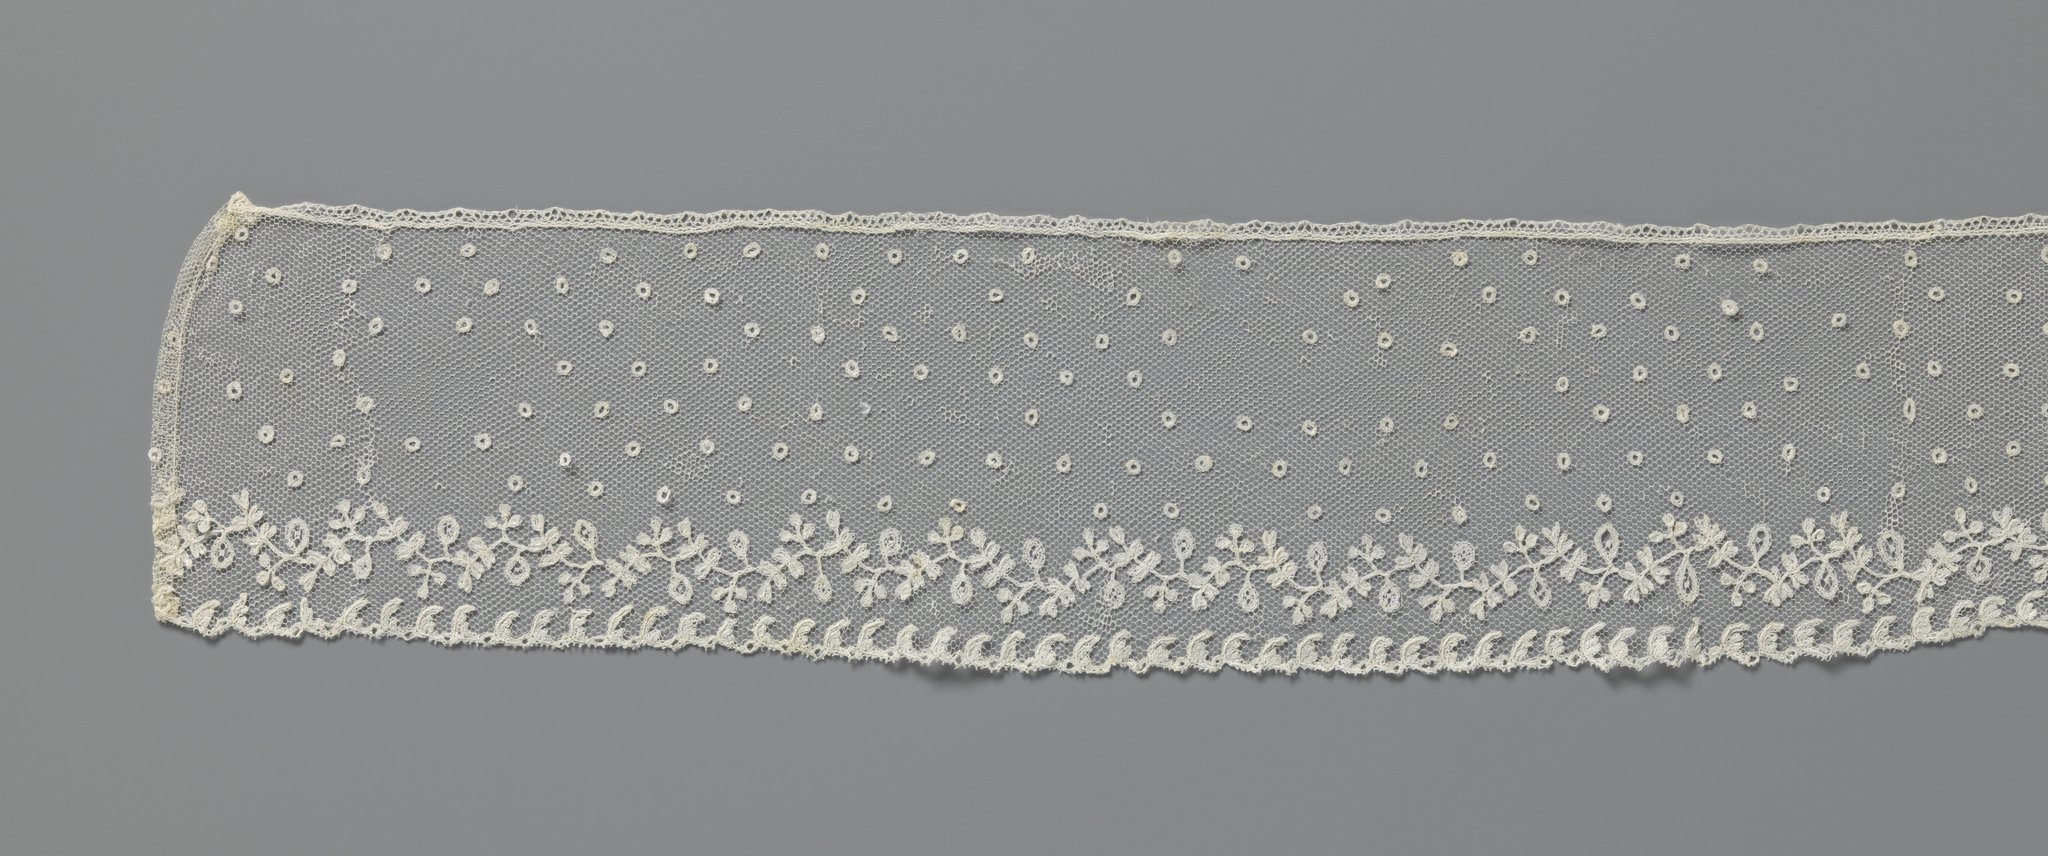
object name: strip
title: Strook applicatiekant met golvende rank en ronde knopjes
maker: Anonymous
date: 1800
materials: linen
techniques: lace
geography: brussels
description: Strook naturelkleurig applicatiekant: Brusselse kloskant geappliceerd op drochelgrond. Dit type kant staat ook bekend onder de naam: point d'Angleterre. Strooipatroon met open moesjes. Langs de fijn geschulpte onderrand van sikkelbladeren loopt een golvende rank waaraan ronde knopjes en diep ingesneden bladeren. Motieven van Brusselse kloskant met de typerende ribben ofwel gekloste reliëfcontouren. Eén soort open siersteek. De bovenzijde is afgezet met een rand kloskant.